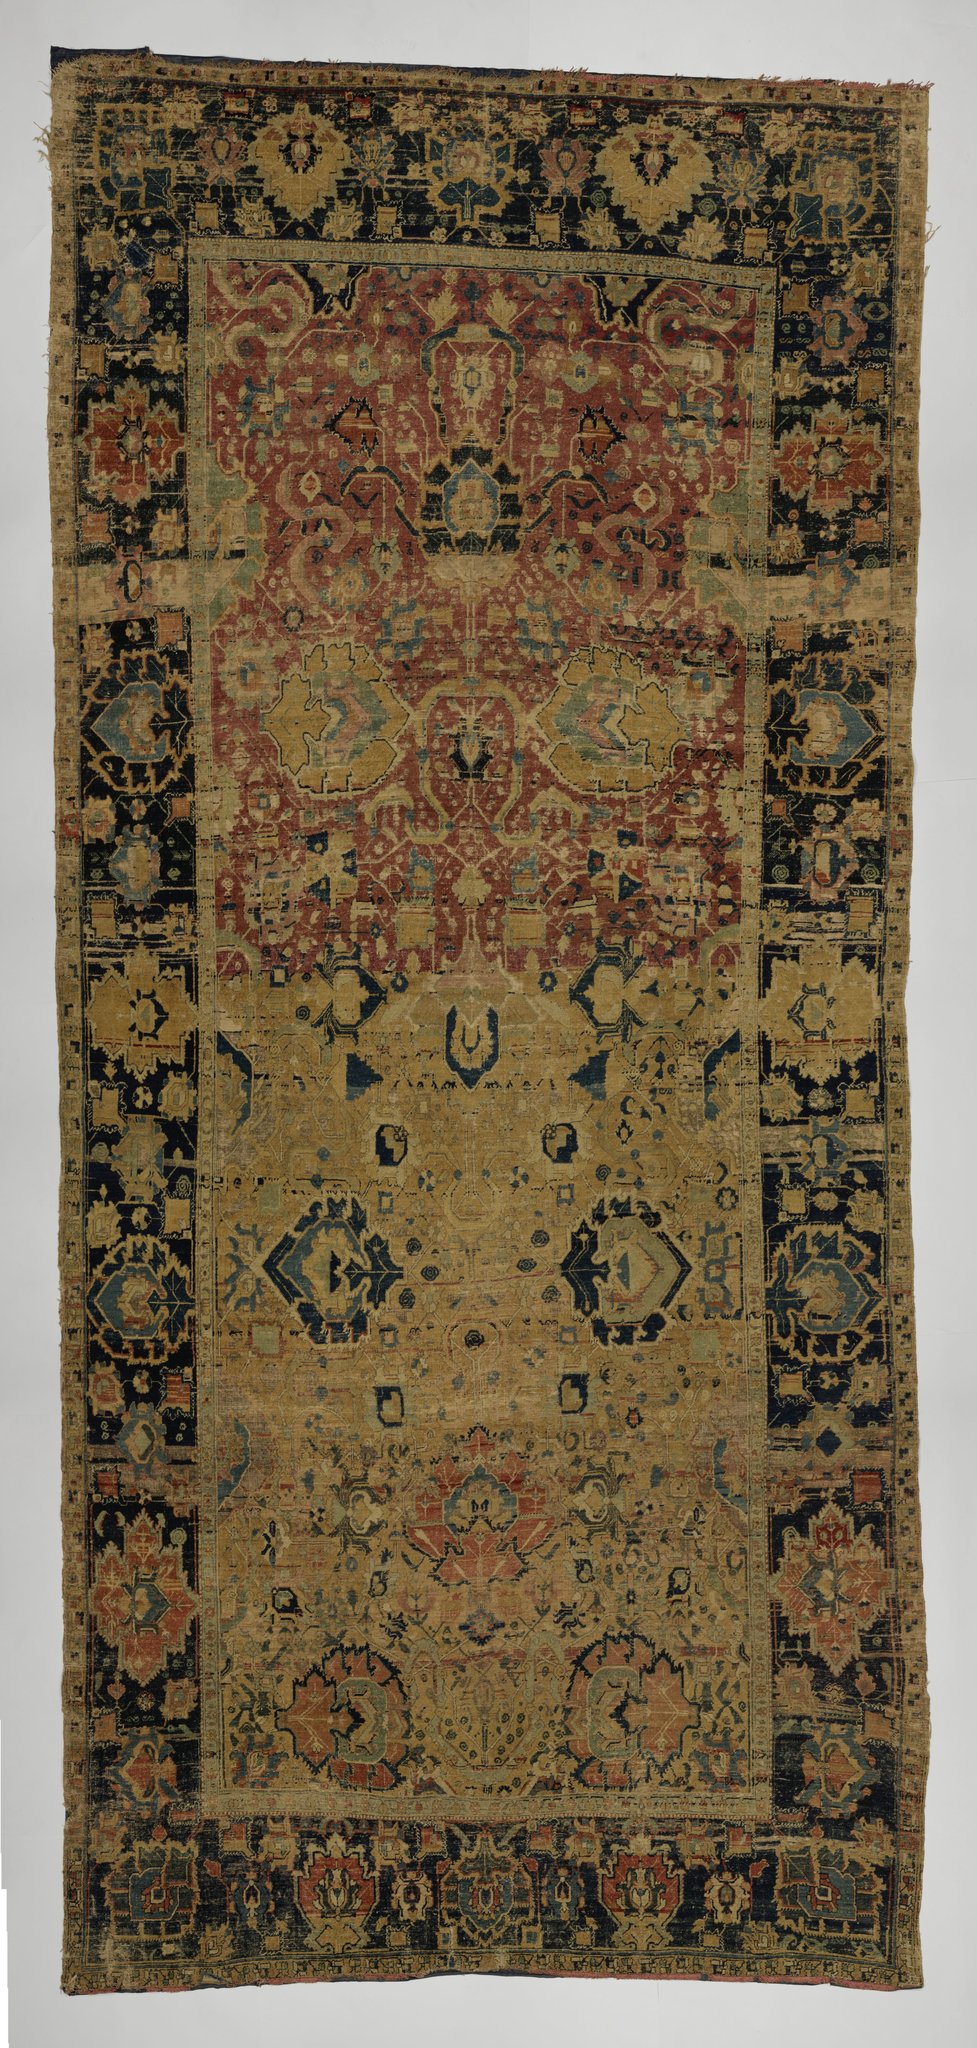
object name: oriental rug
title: Oosters tapijt, zogenaamd ranken- en bloemen kleed. Vervaardigd met Senneh-knoop.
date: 1600-1650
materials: cotton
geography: north persia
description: Tapijt, versierd met grote bloemachtige figuren welke door dunne takken verbonden en hier en daar omstrengeld door de uit China stammende wolkenbanden (Tshi) een bepaald klimmend ornament vormen op een achtergrond die voor de helft licht bruinachtig geel, voor de helft licht rood is getint. Op de rand dezelfde bloemfiguren tegen een grond van donker indigo.